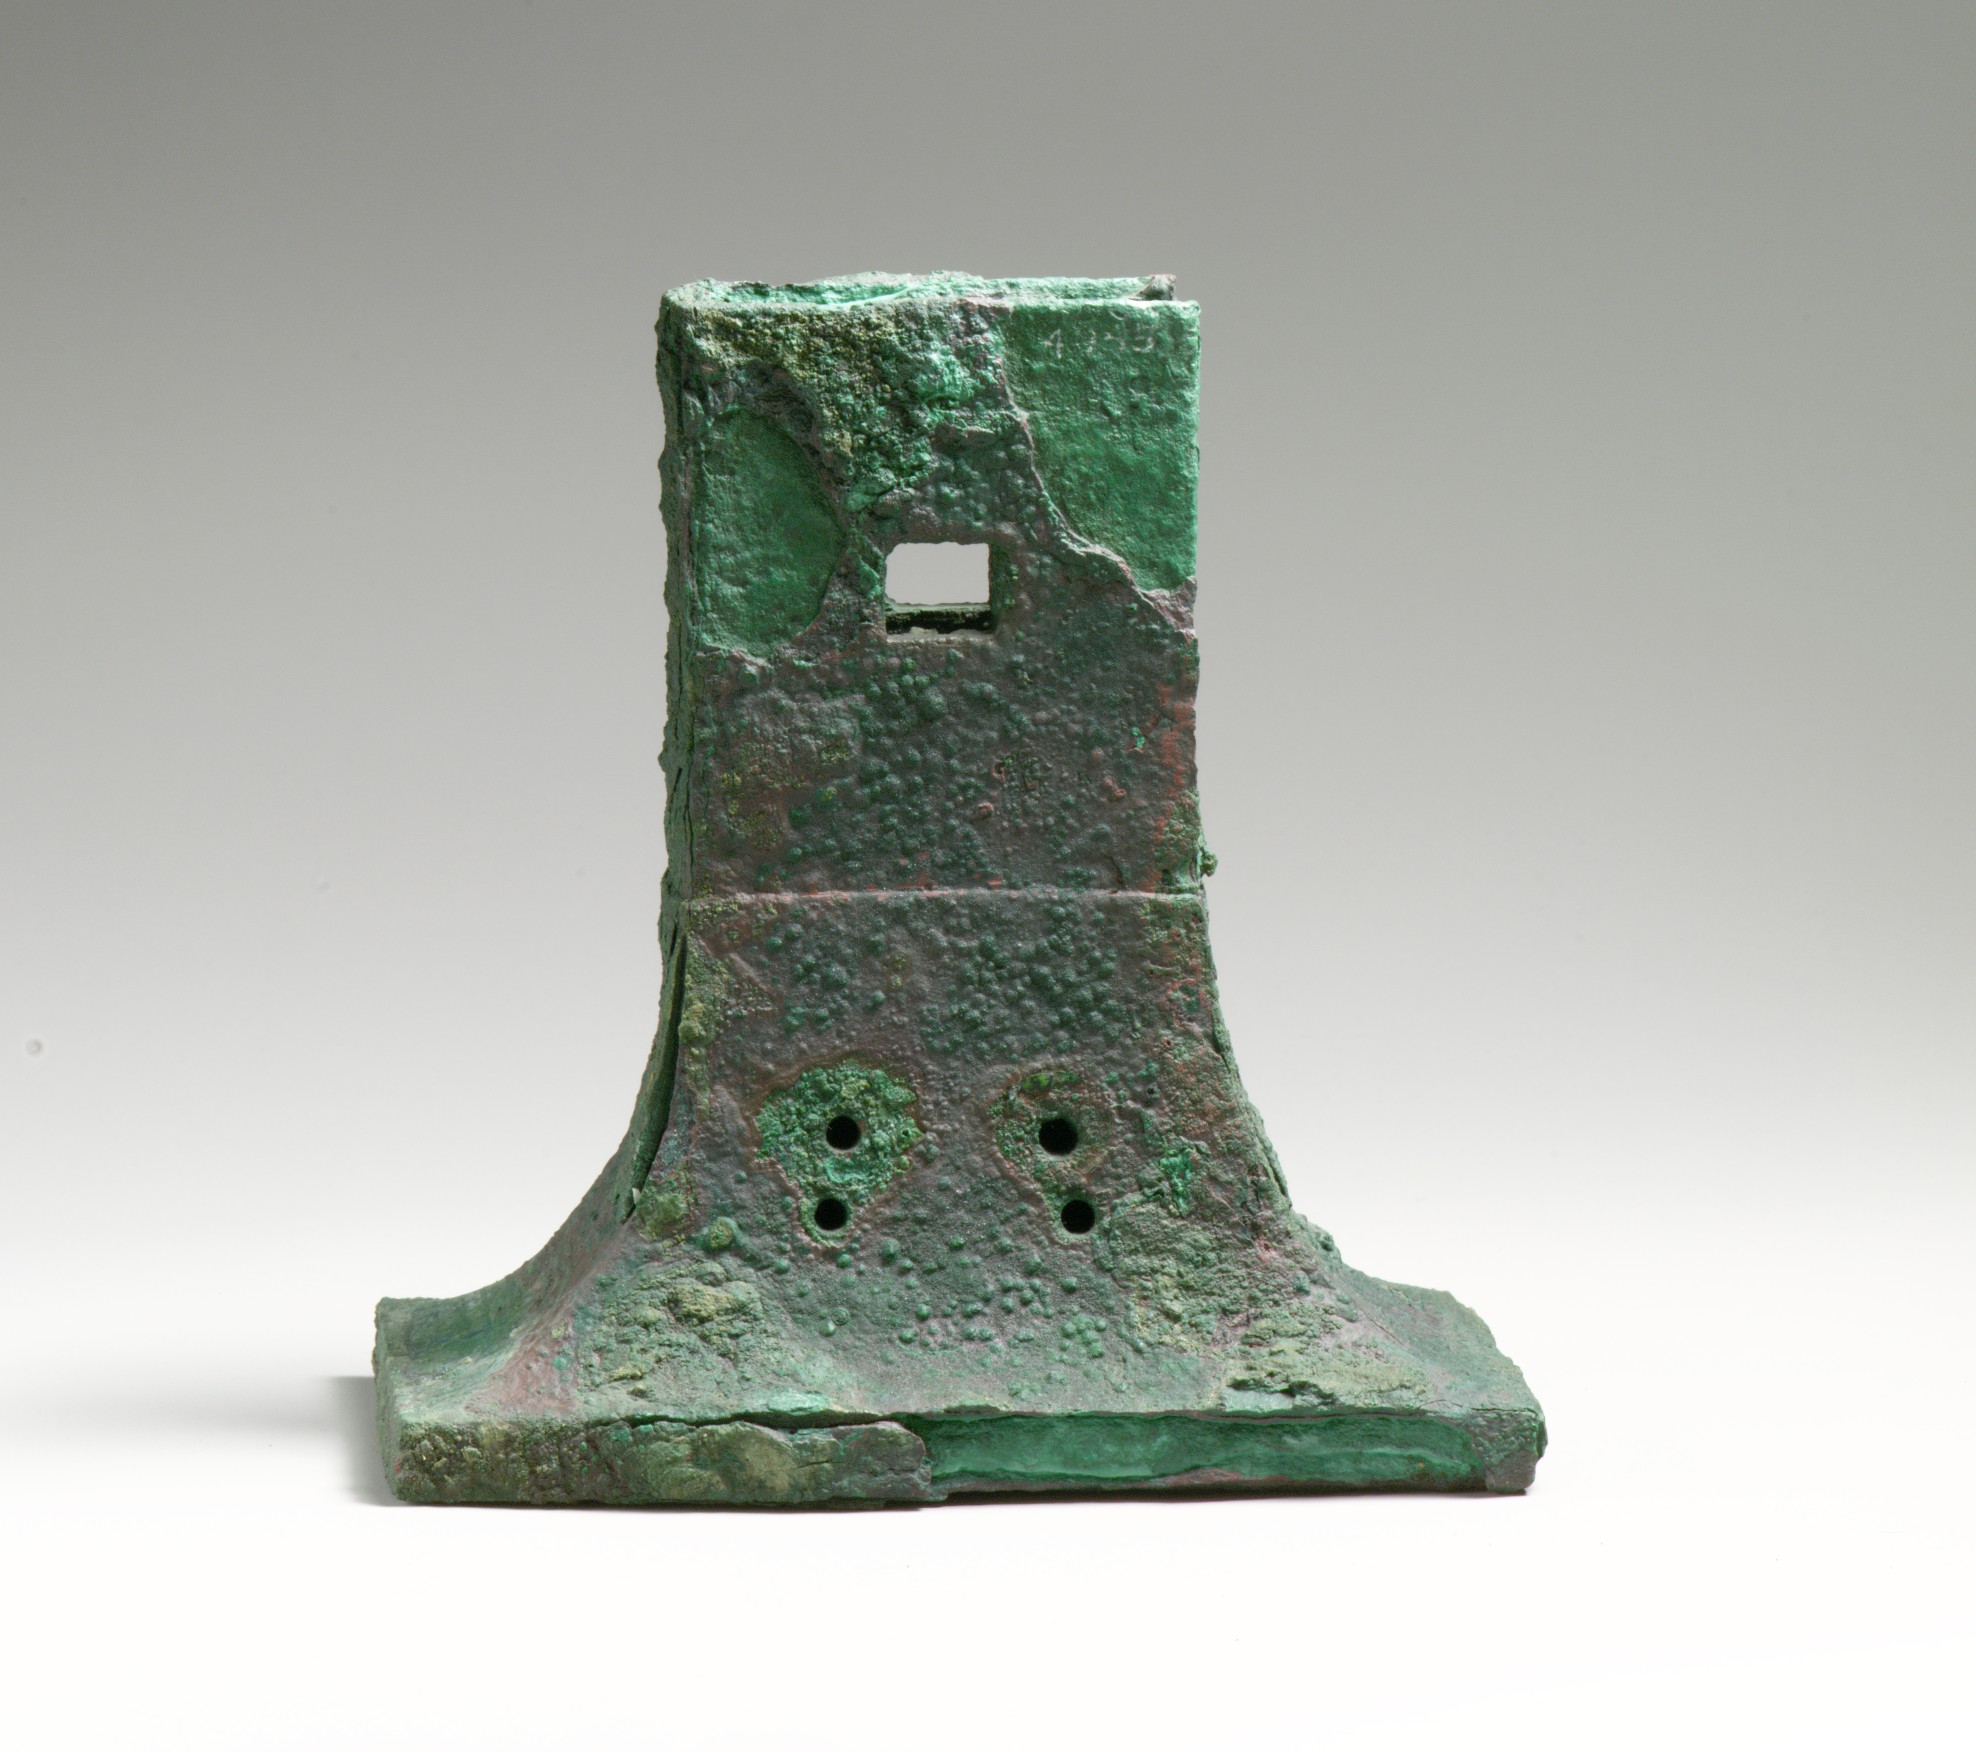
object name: furniture socket, rectangular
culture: cypriot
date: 3900 BCE-100 CE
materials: bronze